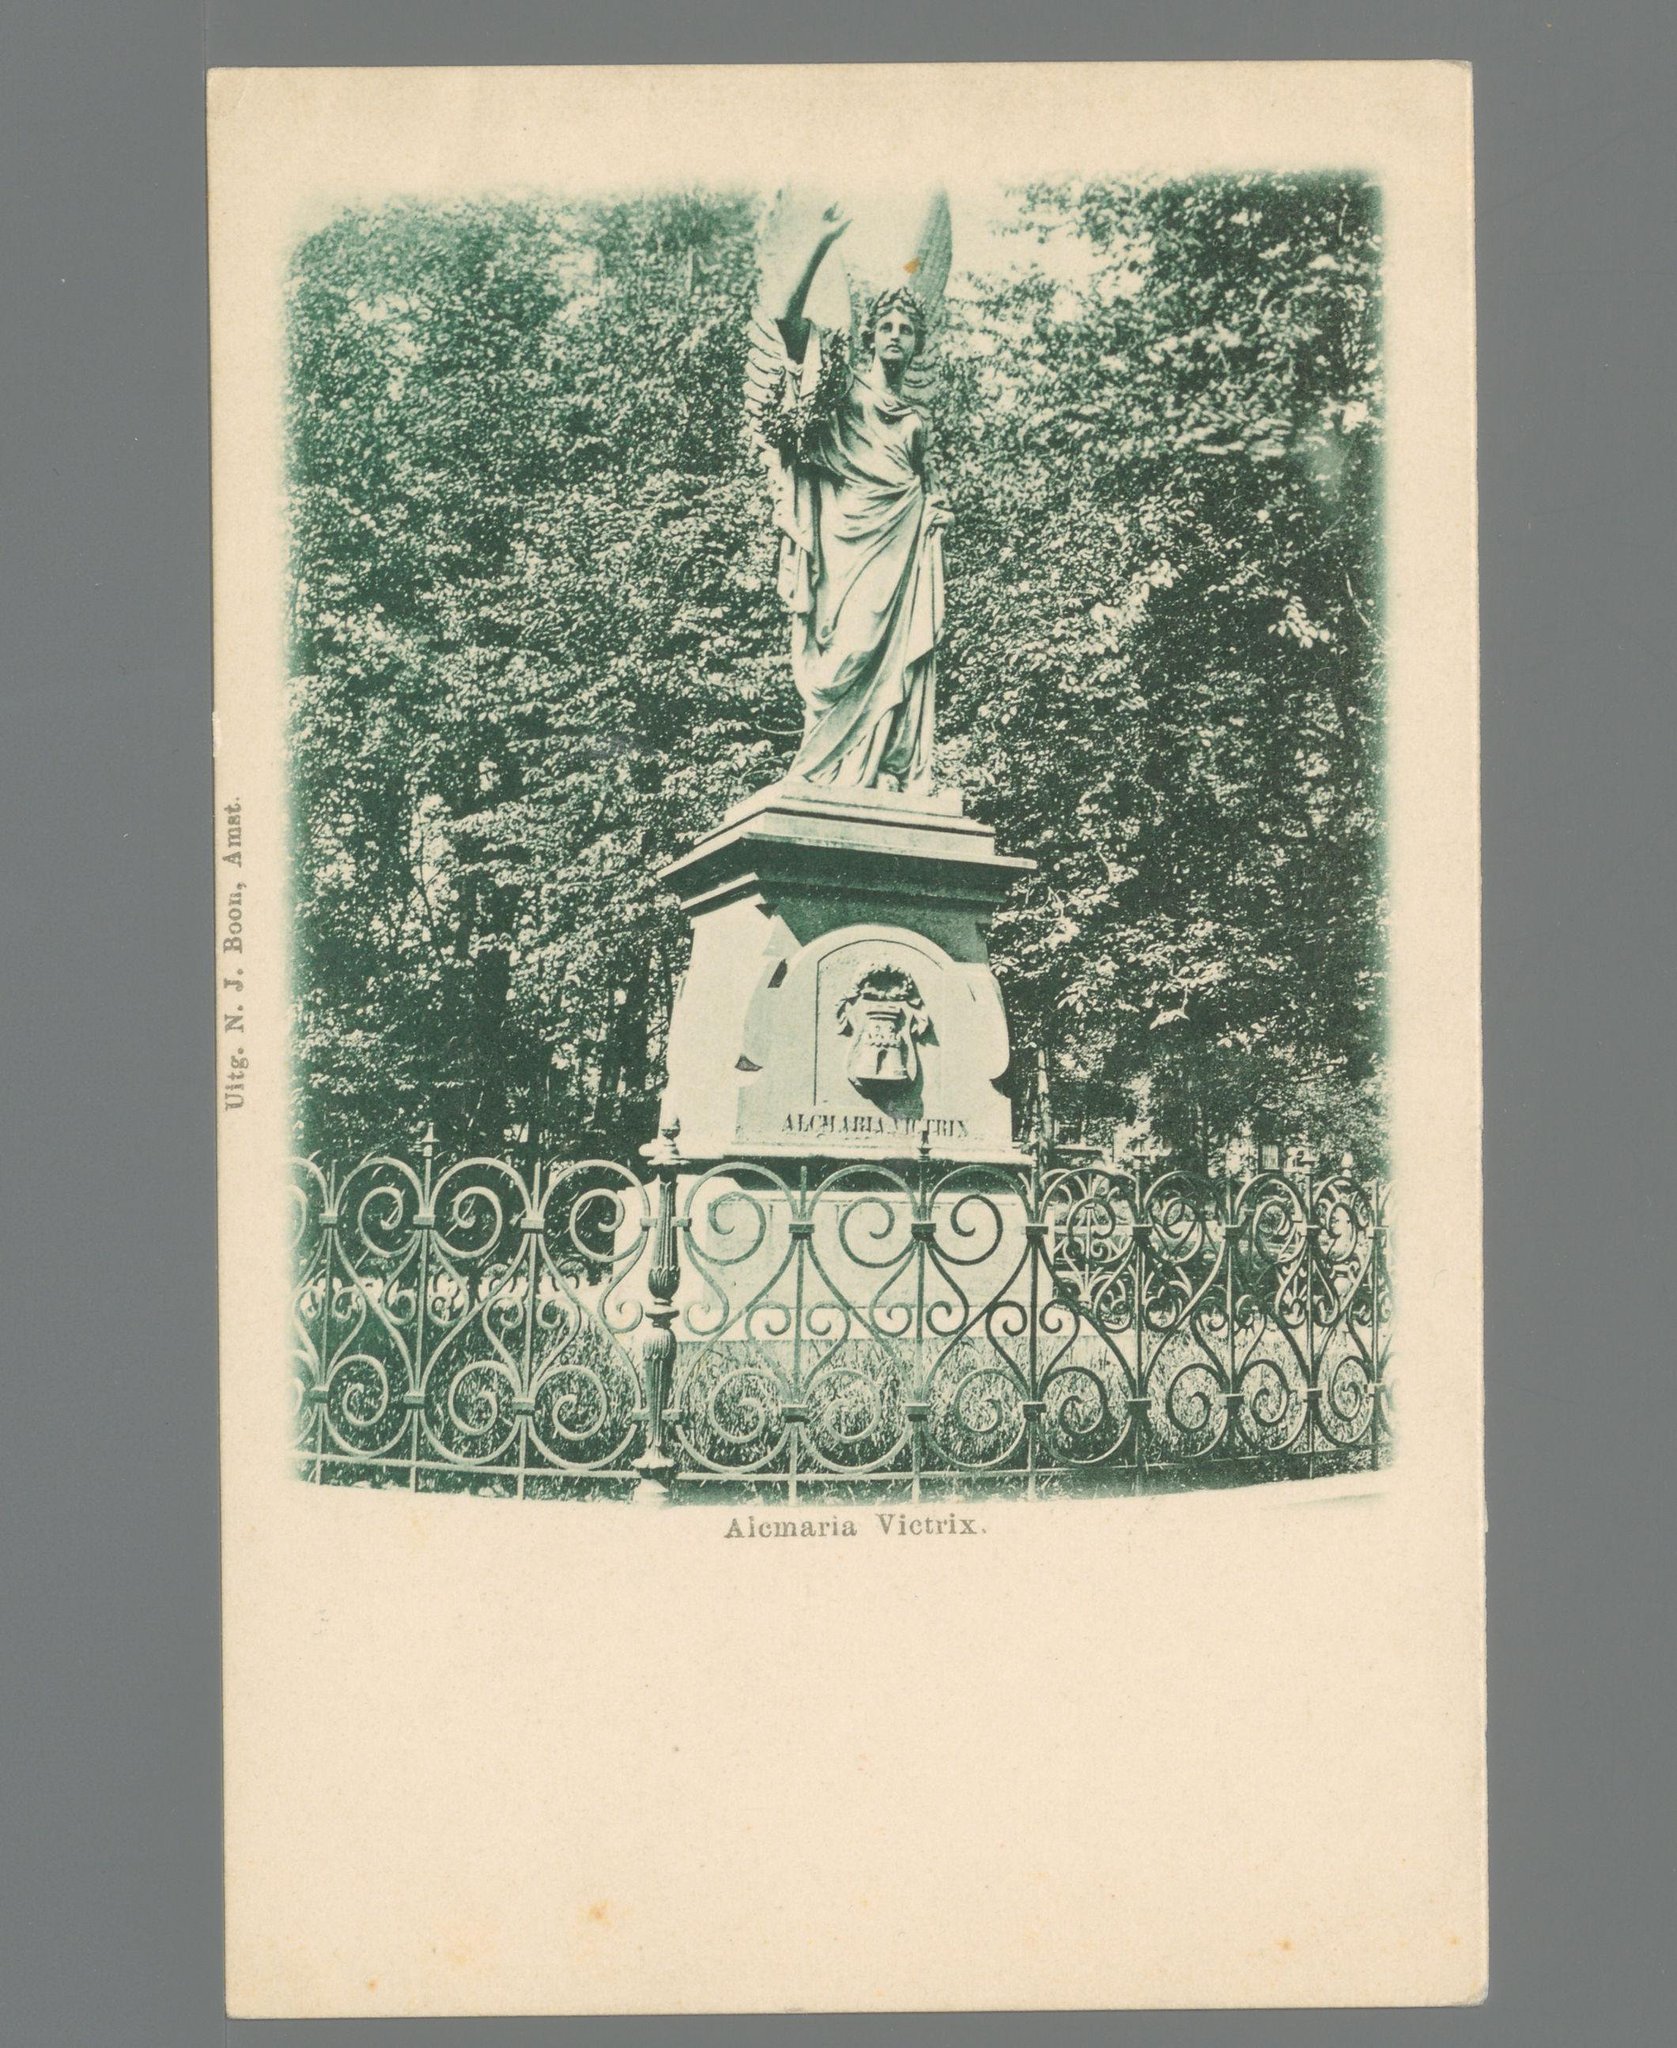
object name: ansichtkaart, prentbriefkaart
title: Alcmaria Victrix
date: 1895-1905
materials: cardboard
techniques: photograph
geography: amsterdam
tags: fence, wall, paling, monument, statue